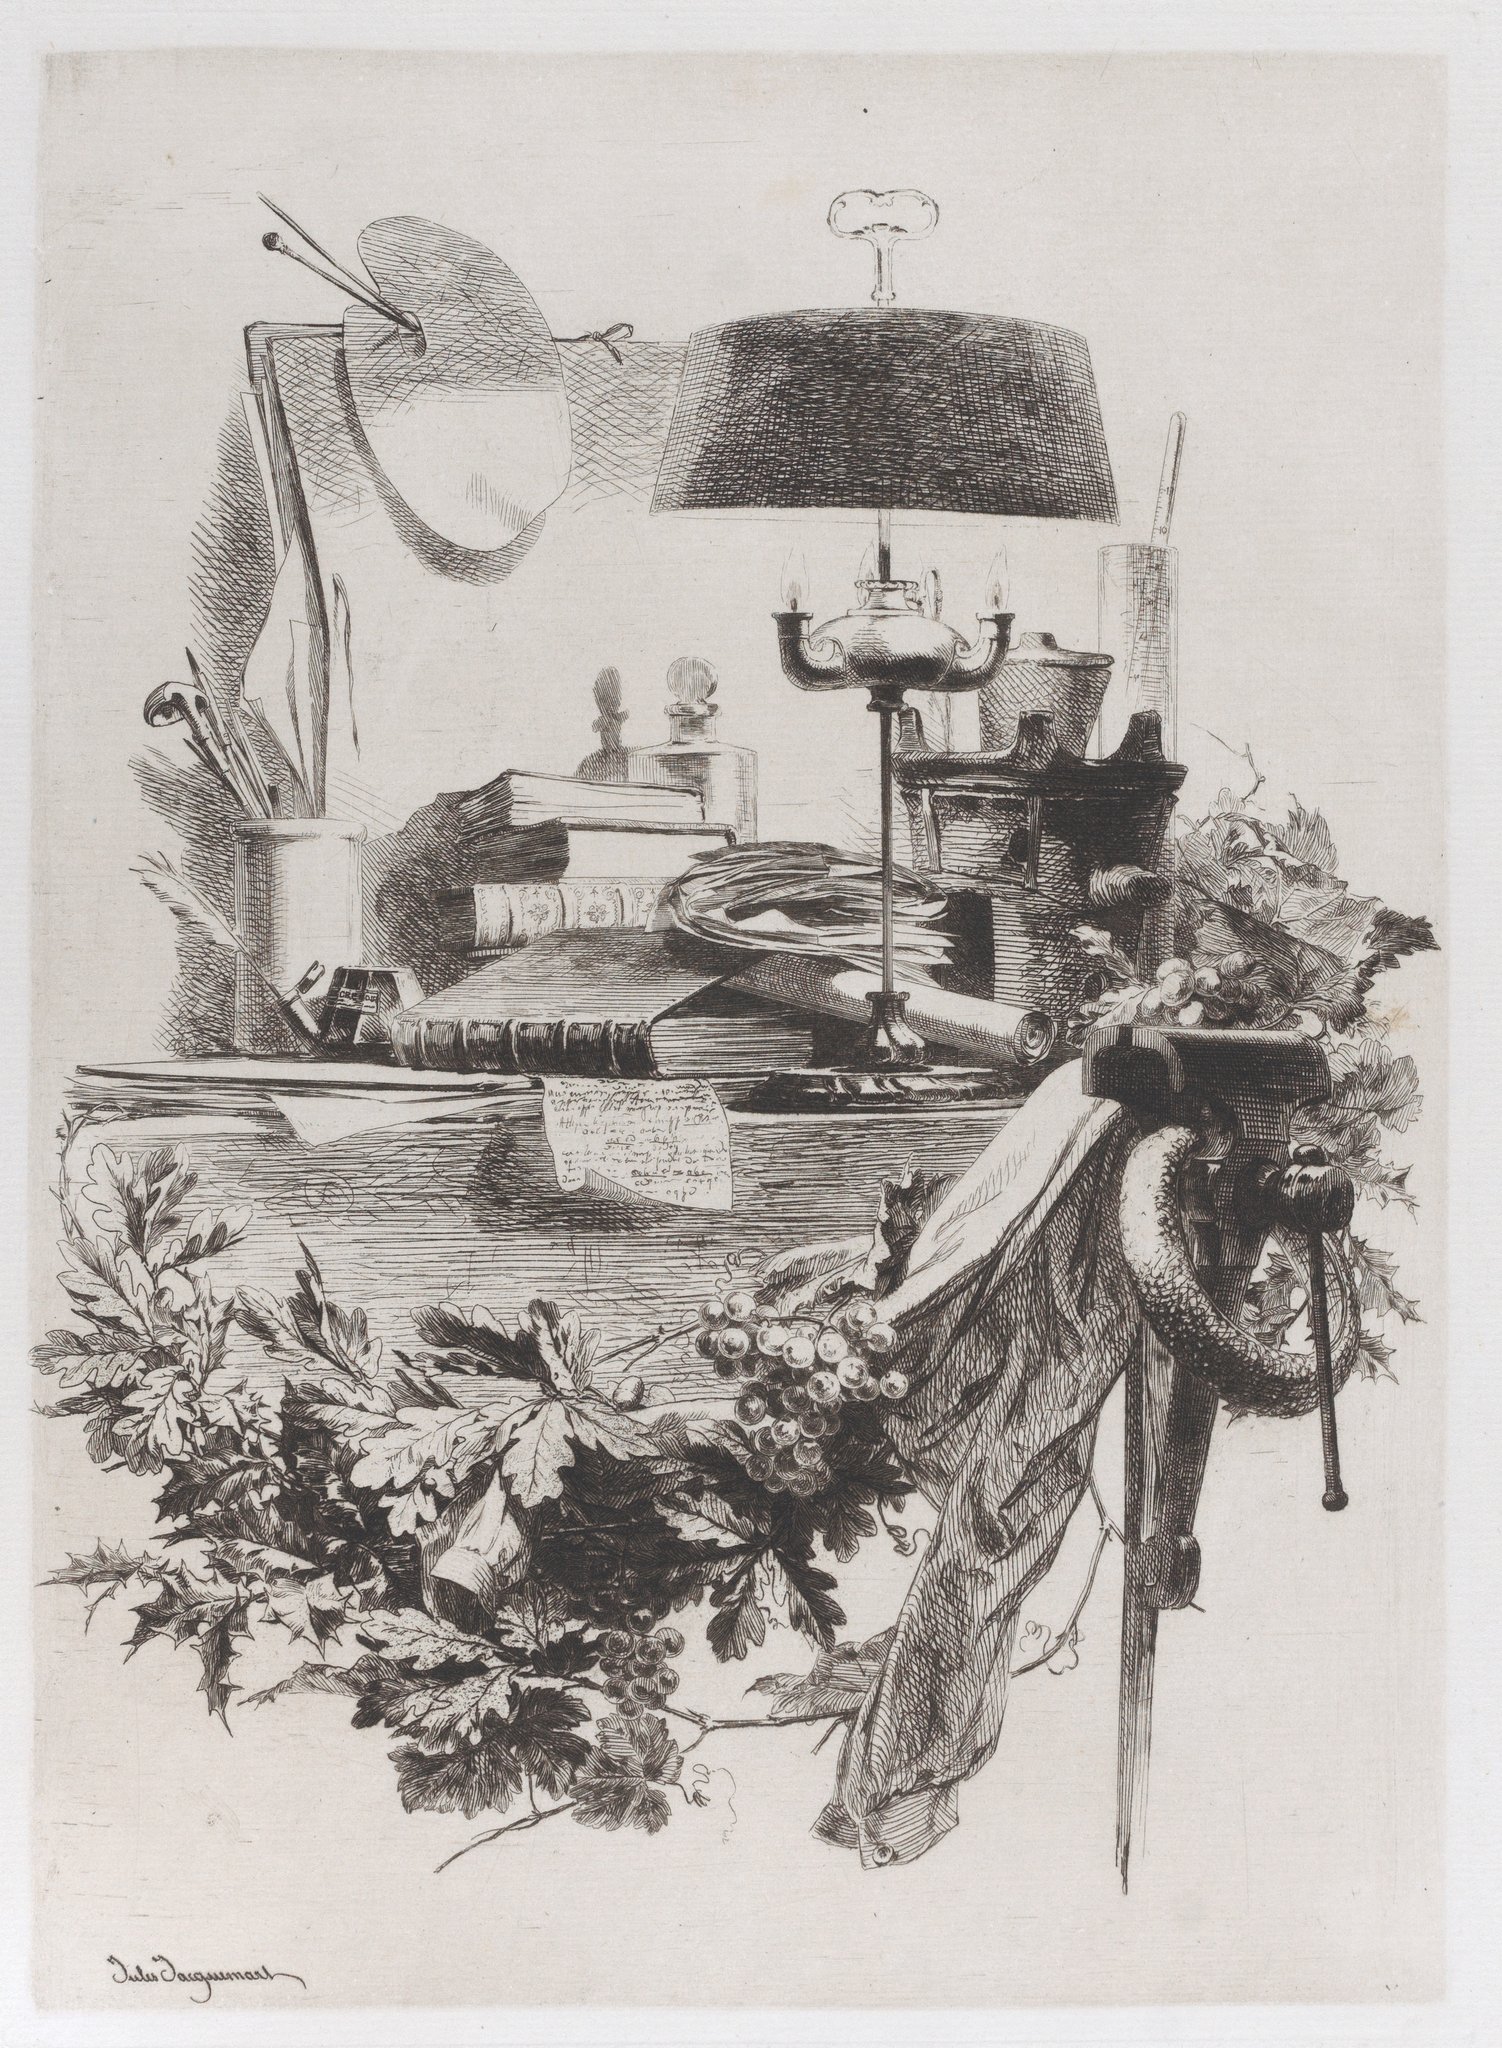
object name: print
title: The Engraver's Instruments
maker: jules-ferdinand jacquemart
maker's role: artist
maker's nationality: french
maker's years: 1837-1880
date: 1862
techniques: etching